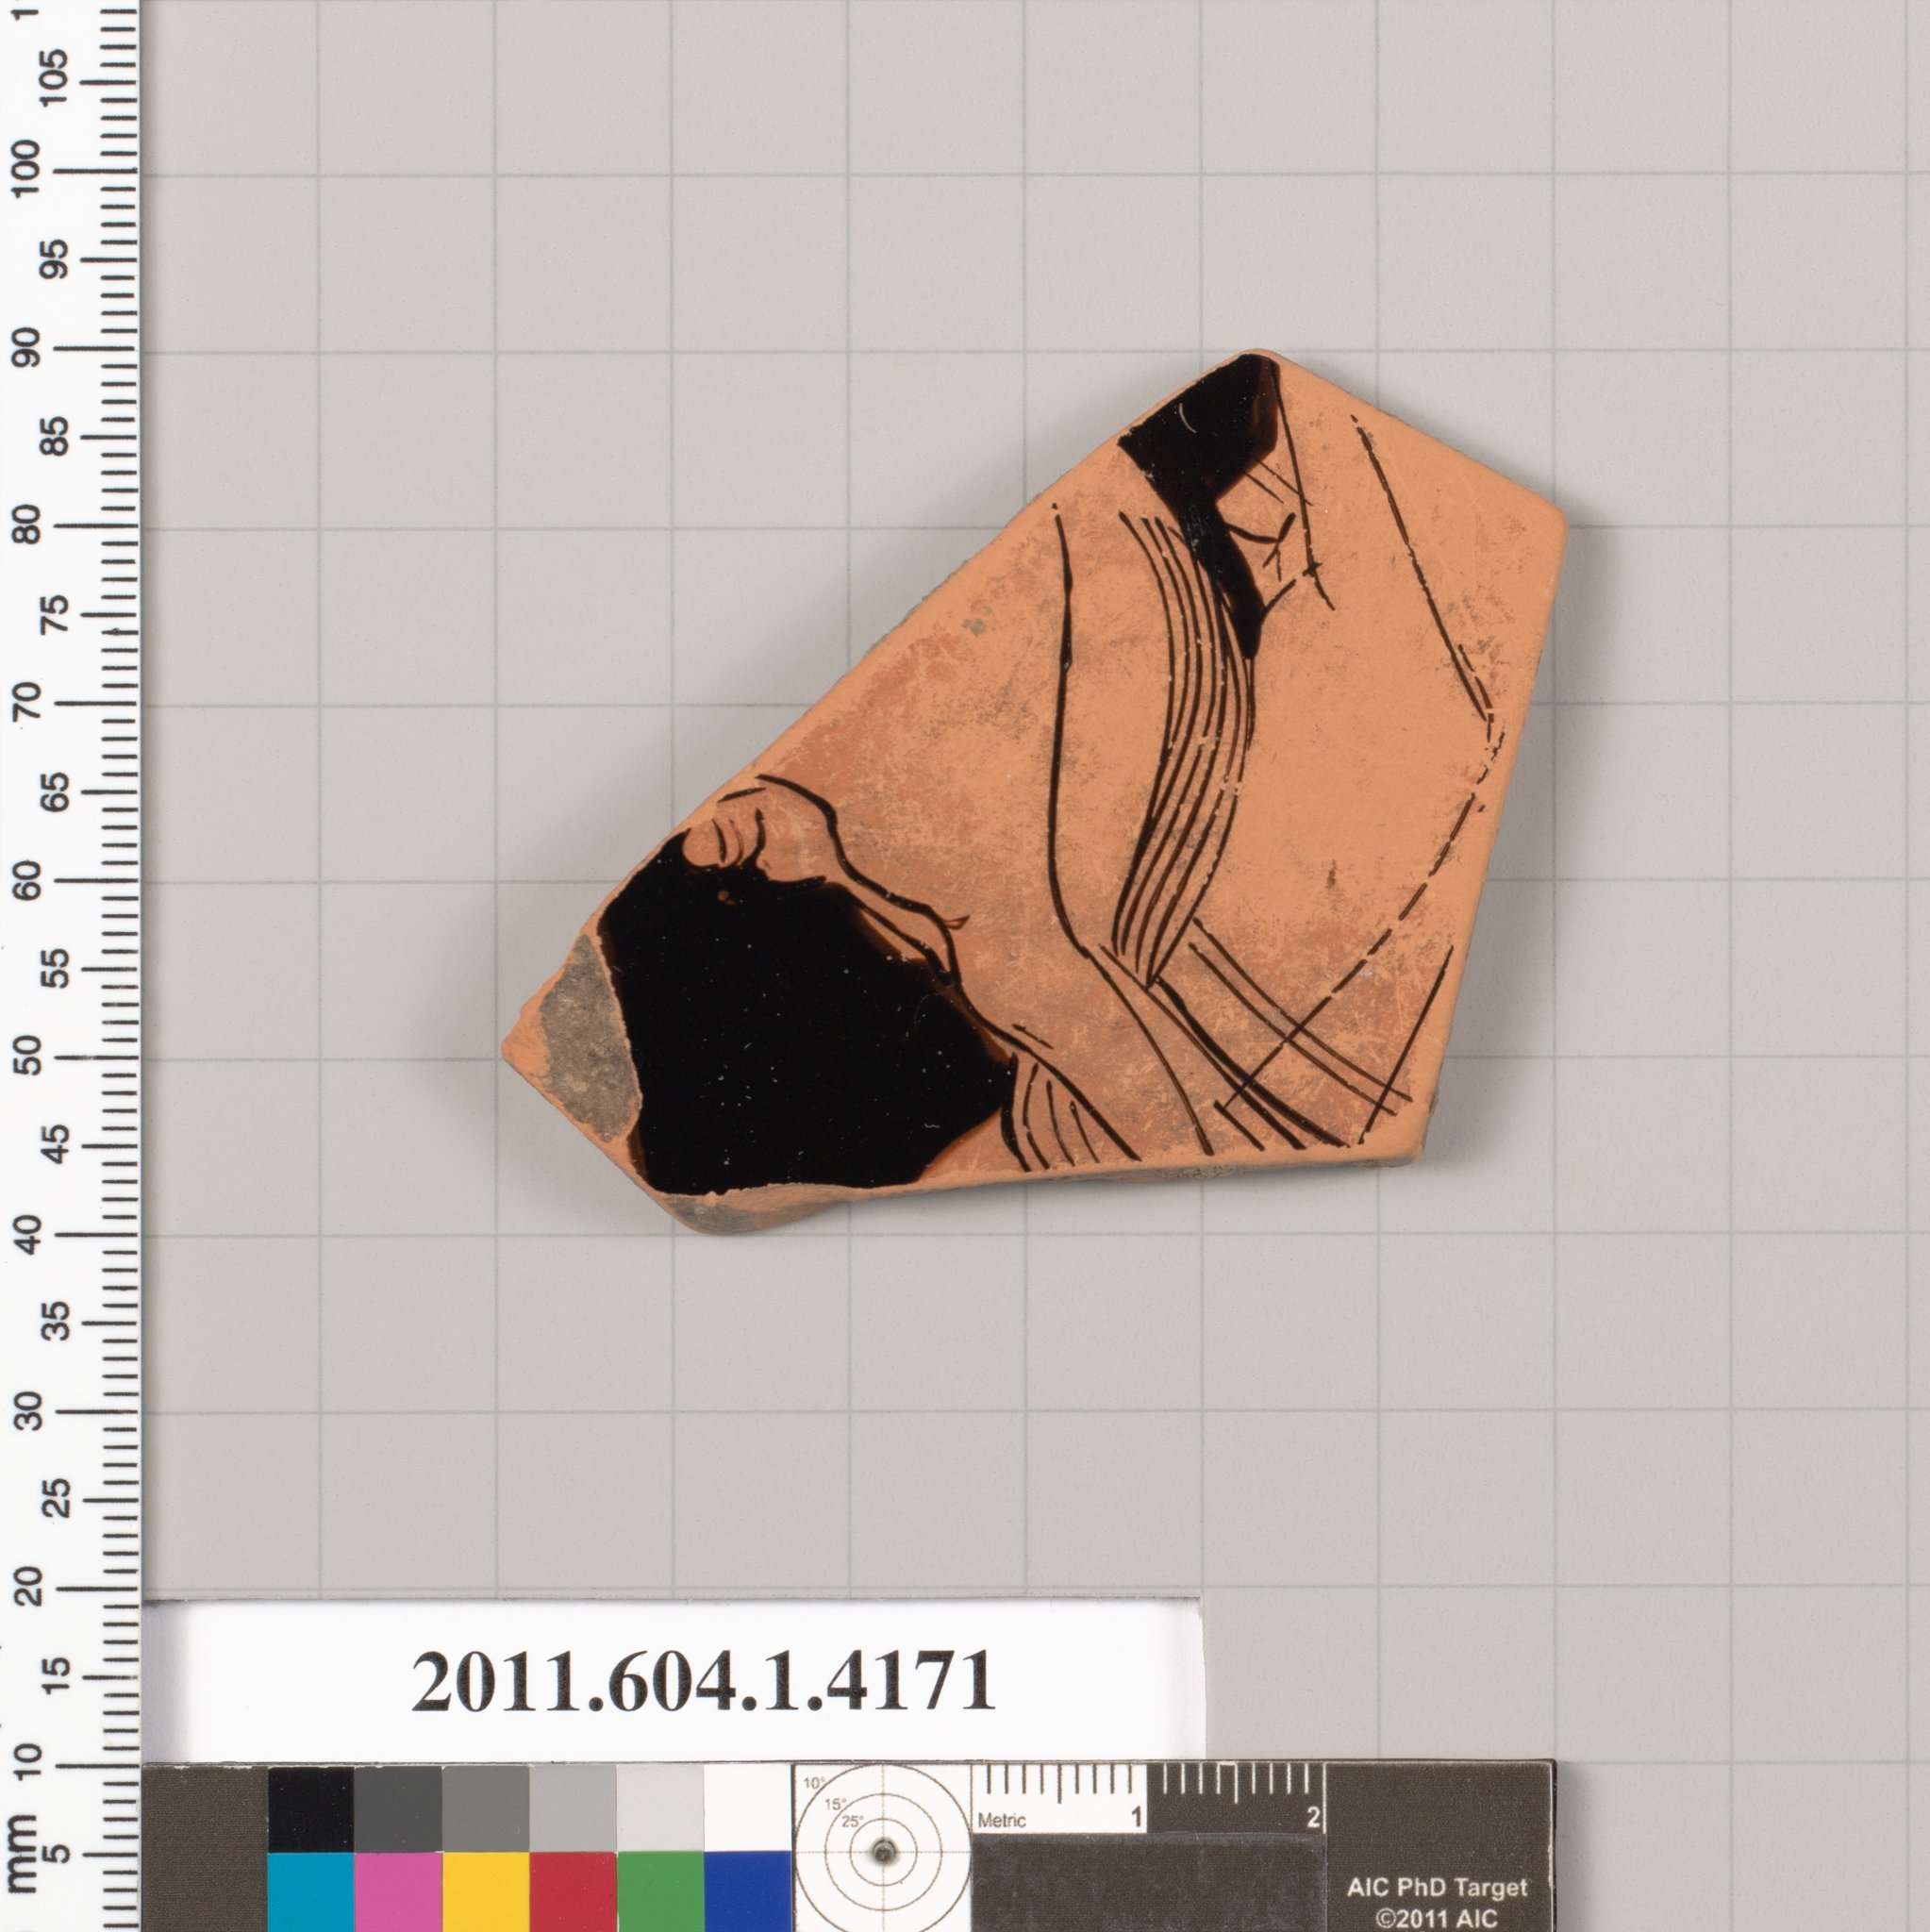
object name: kylix fragment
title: Terracotta fragment of a kylix (drinking cup)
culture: greek, attic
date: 500-480 BCE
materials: terracotta